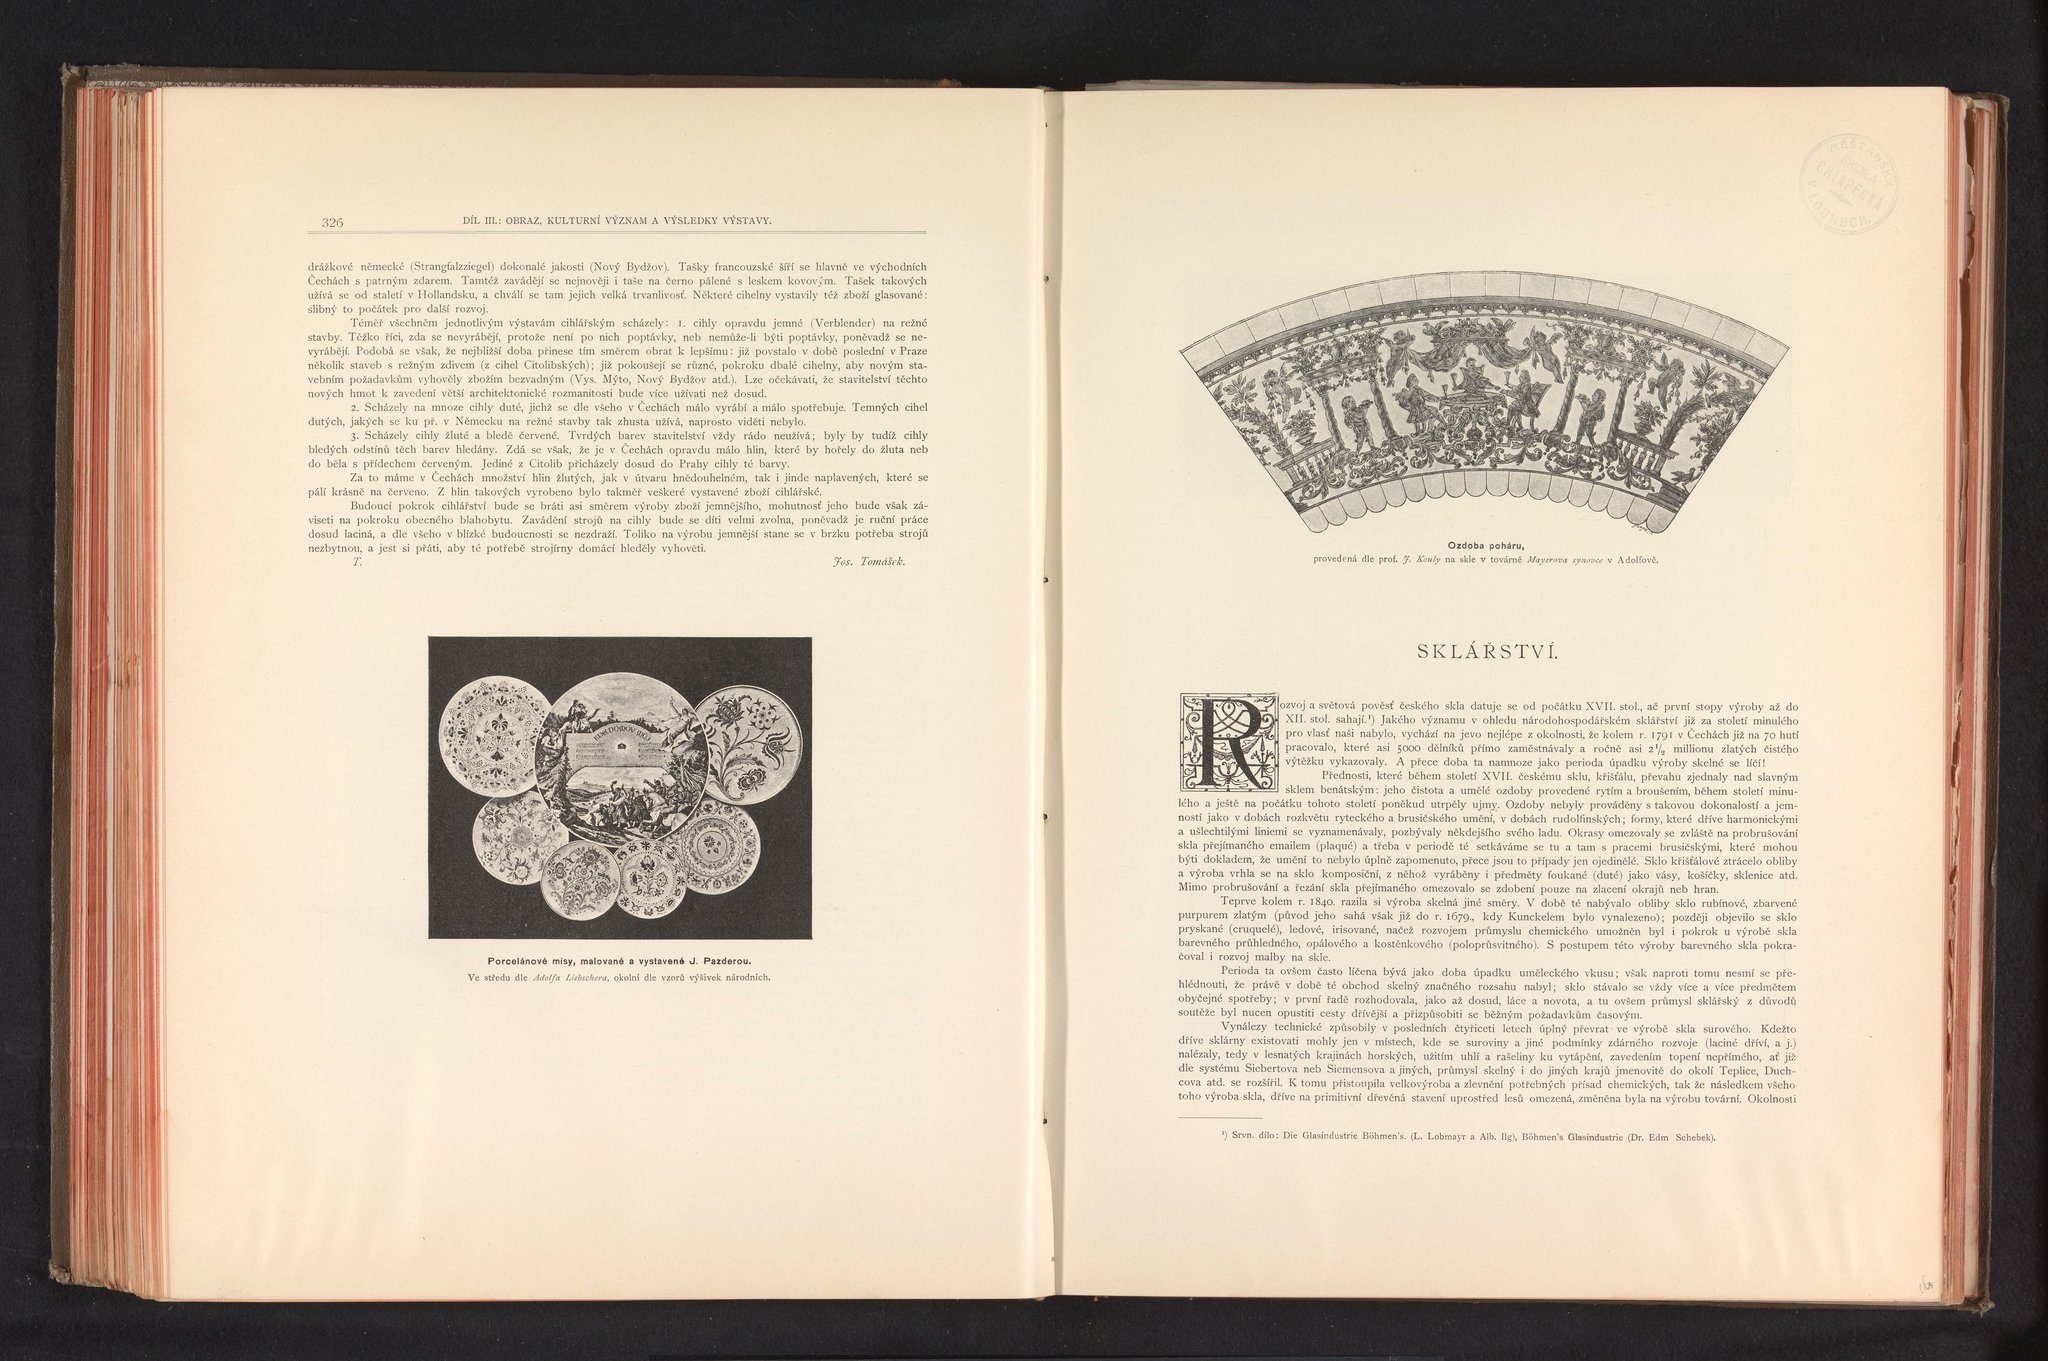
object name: page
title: Fotoreproductie van een tekening, voorstellende de decoratie van een beker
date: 1890-1895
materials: paper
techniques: autotype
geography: prague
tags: ornament derived from objects